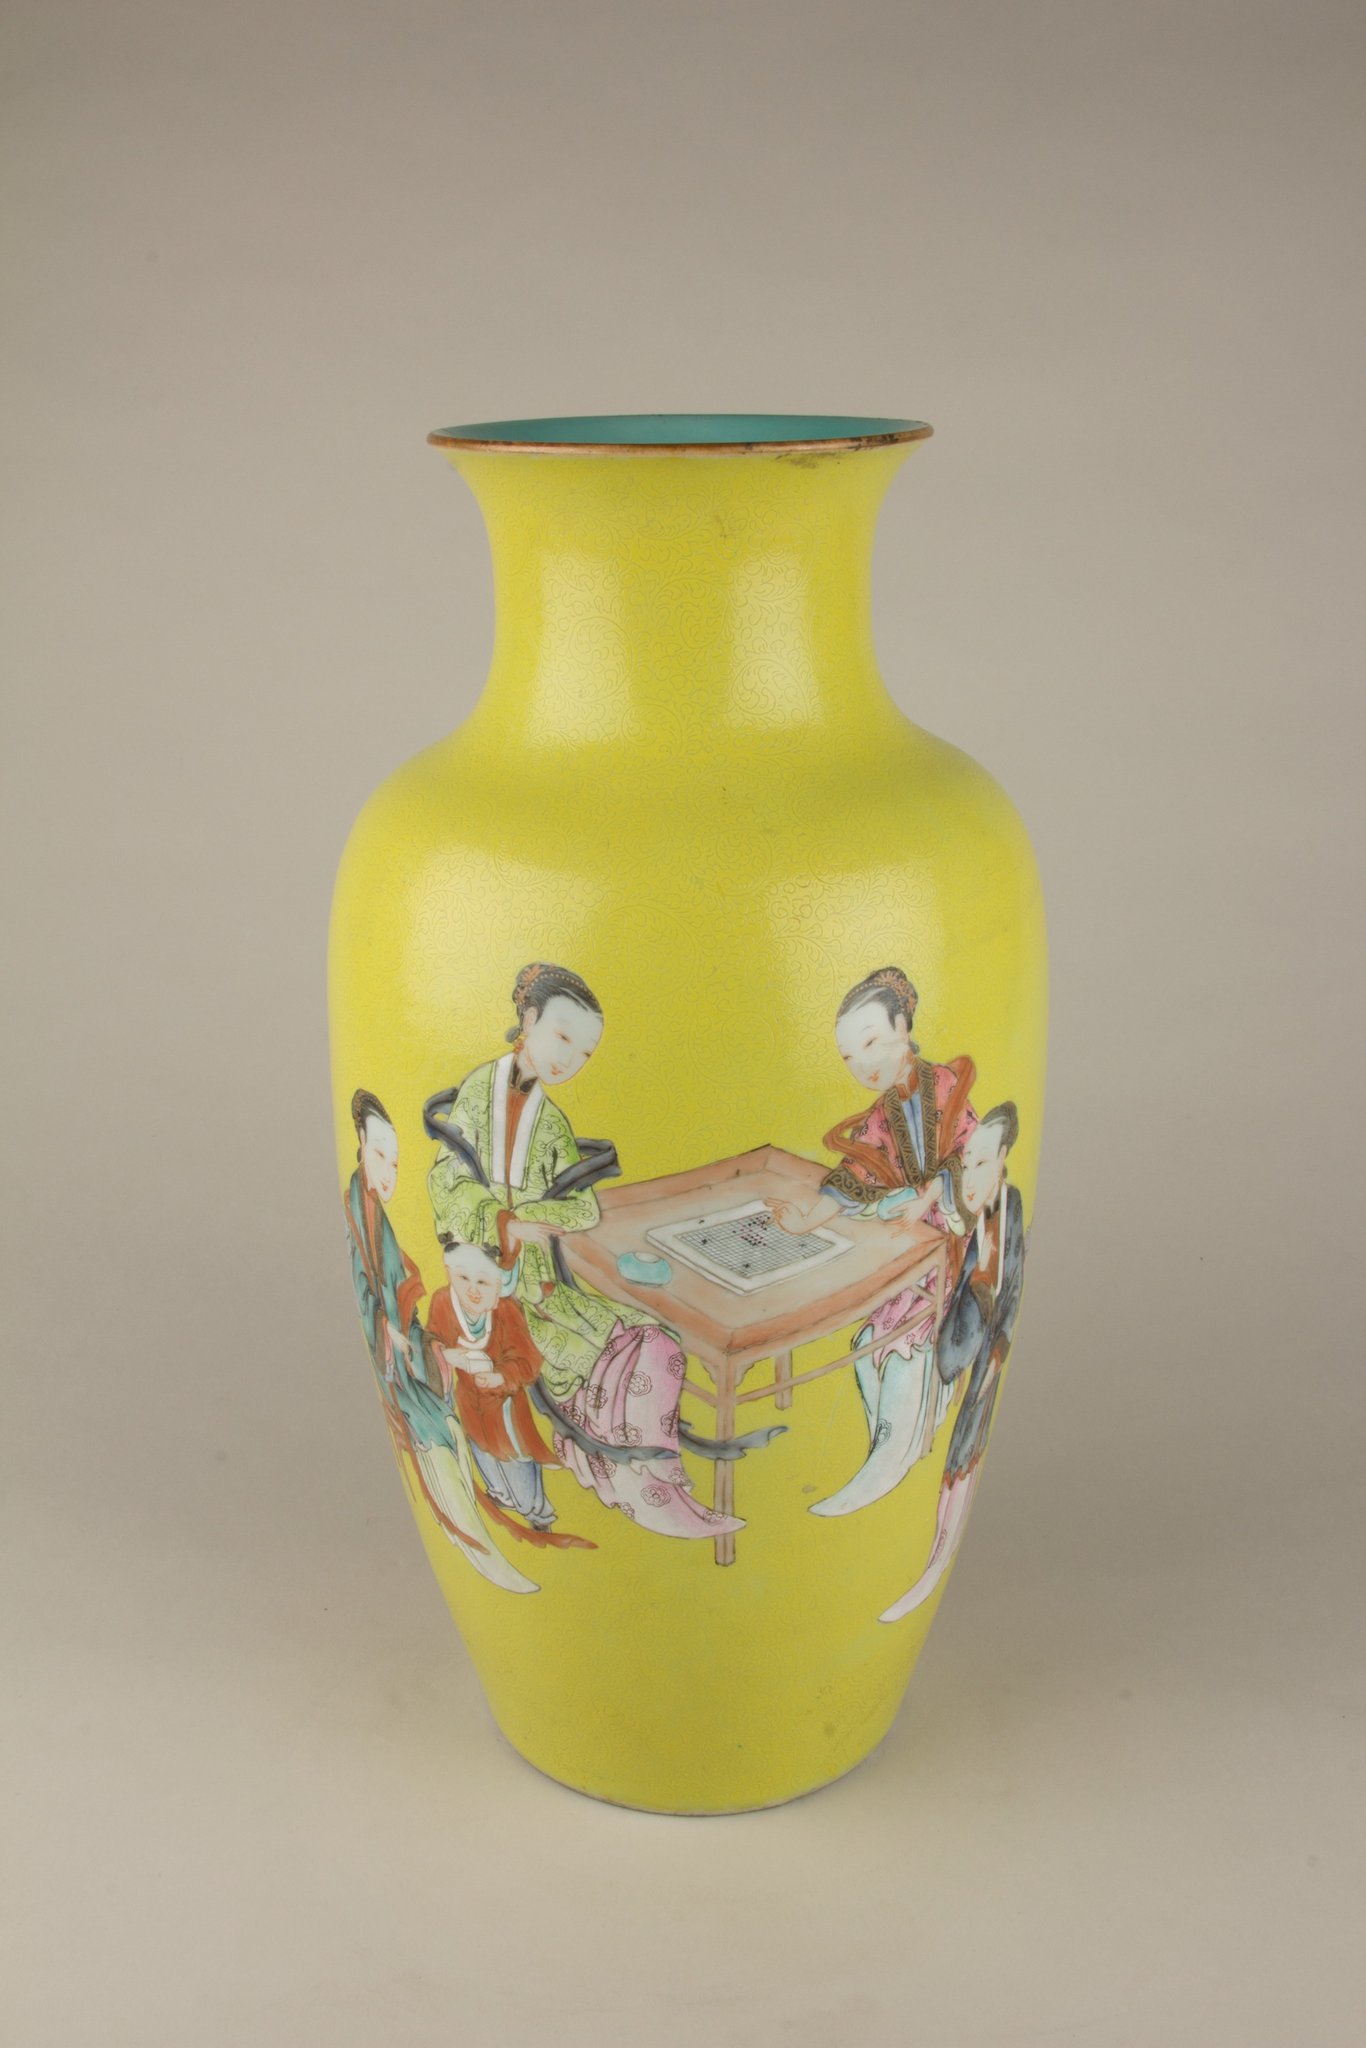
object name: vase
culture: chinese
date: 1736-1795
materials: enamel, porcelain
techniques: painting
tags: children,women,playing,games